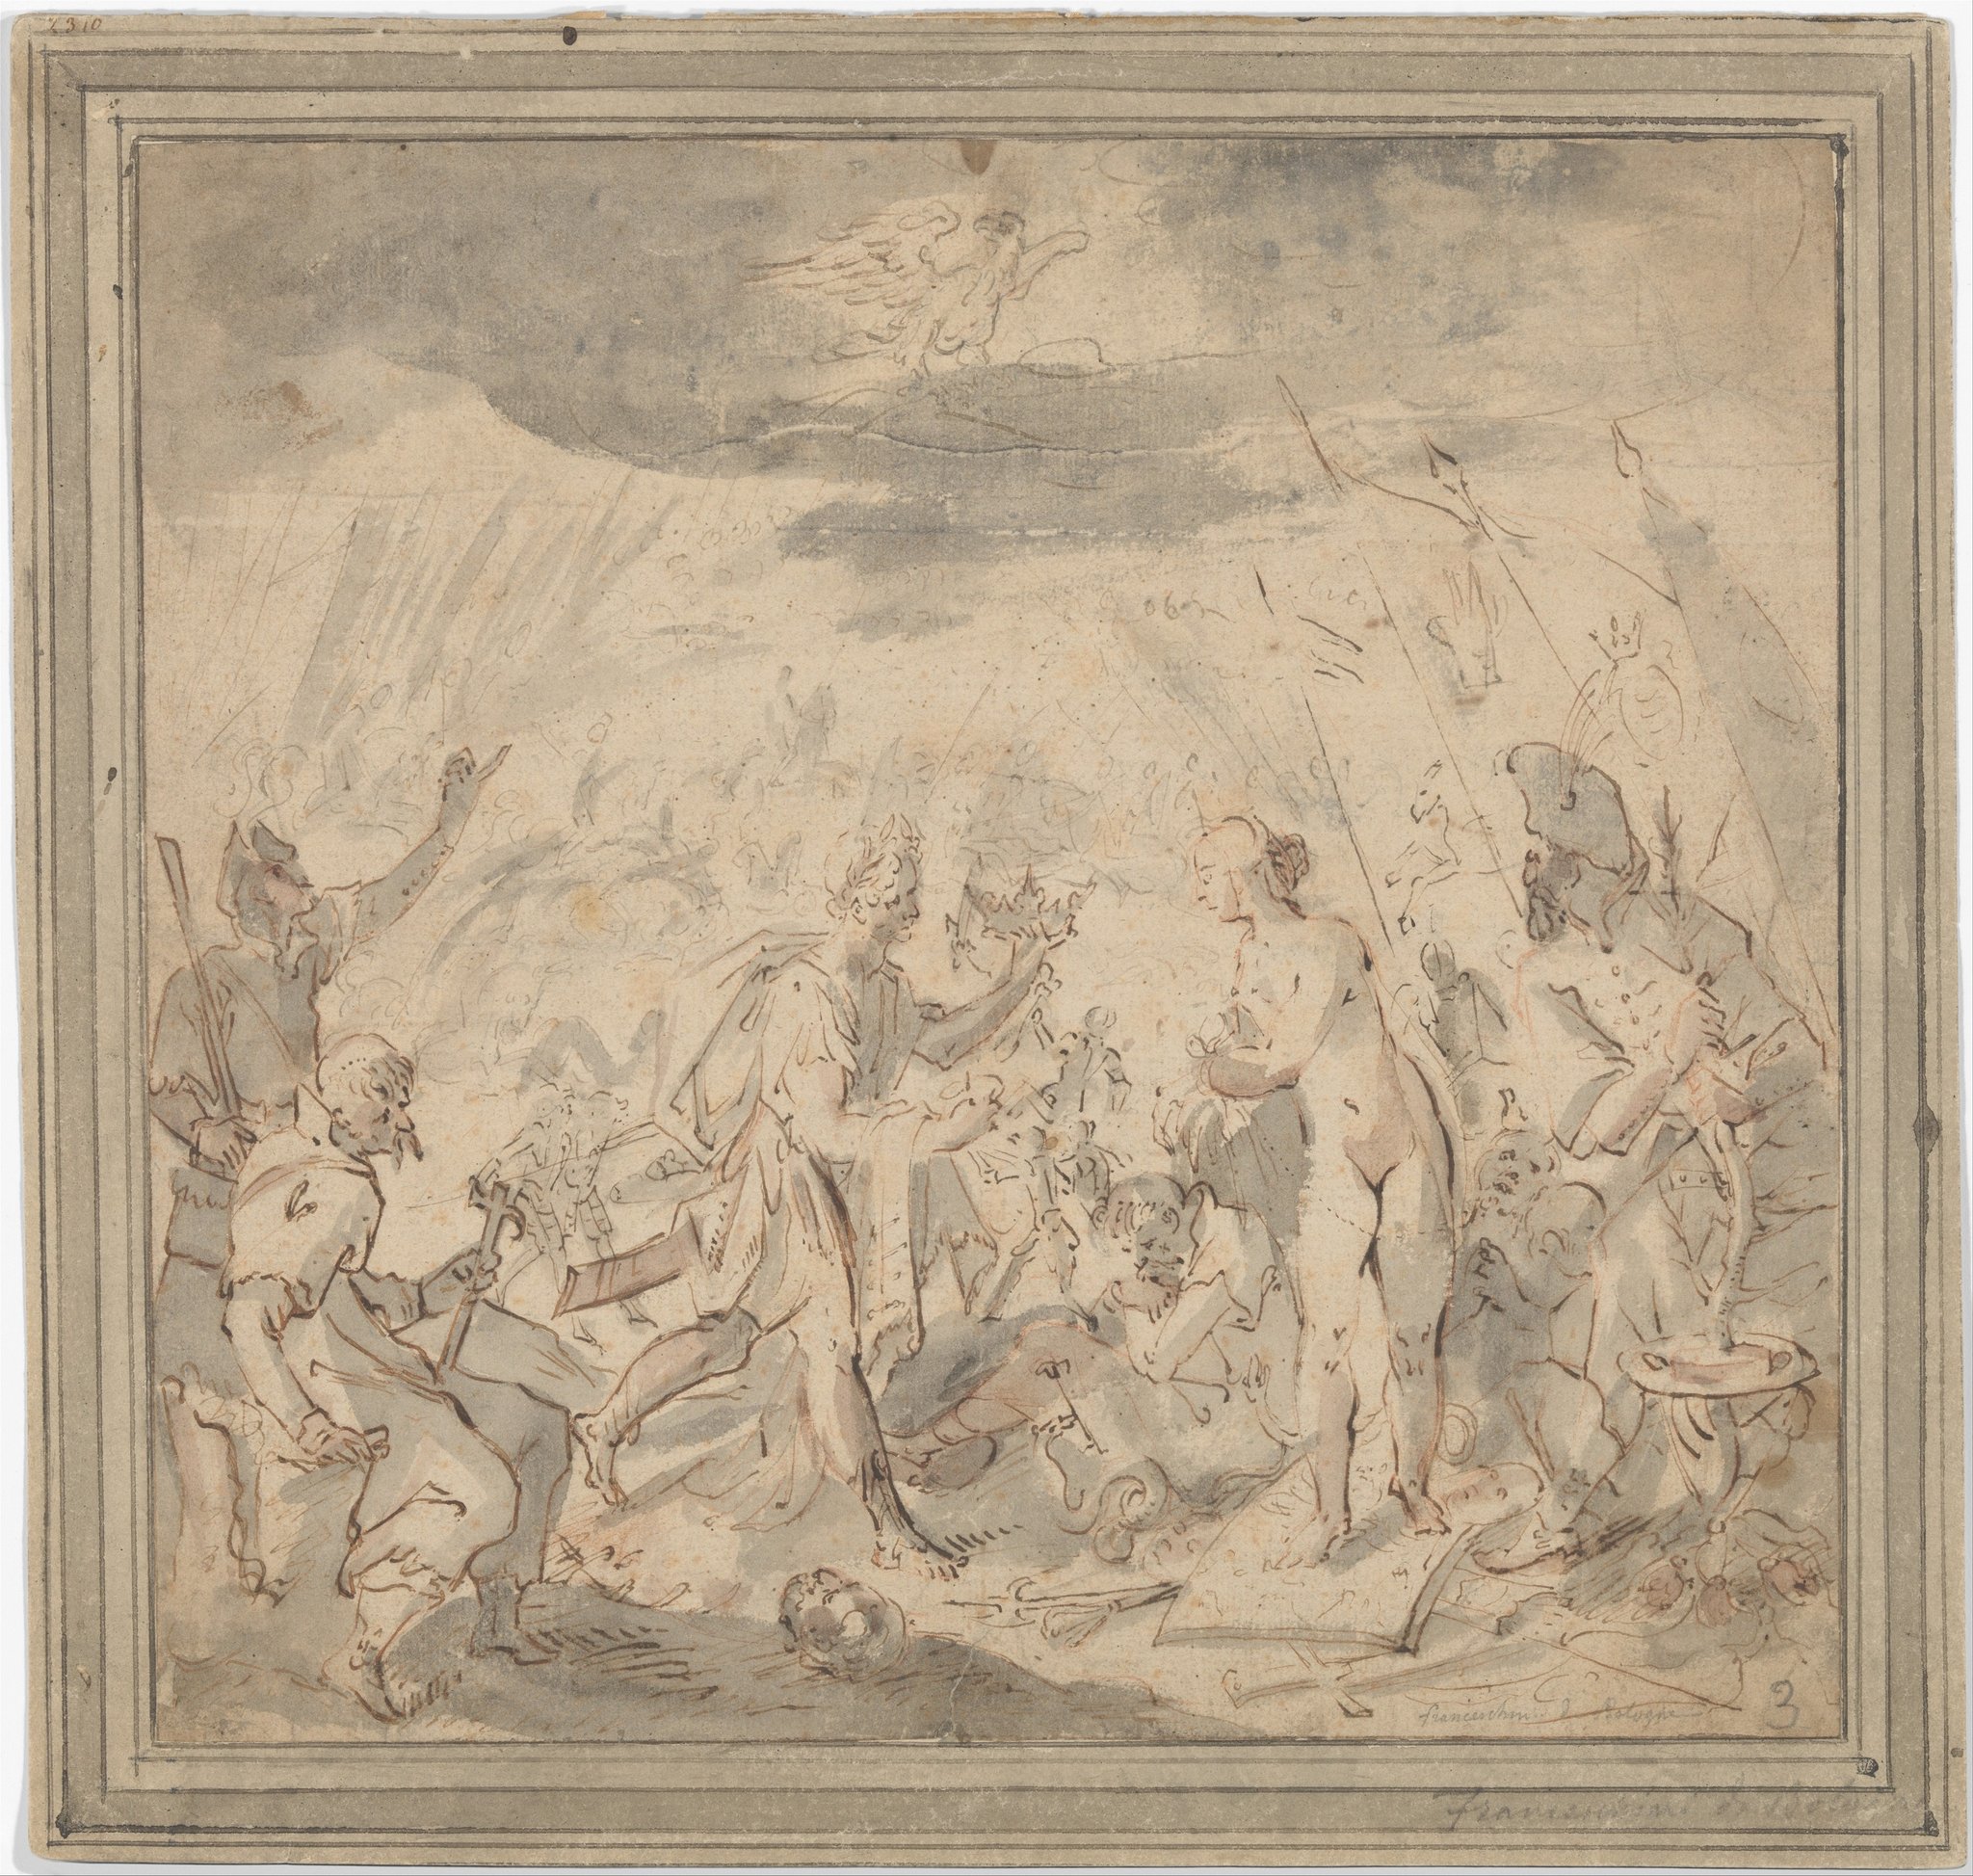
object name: drawing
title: Allegory of the Battle at Selimbar (October 28, 1599)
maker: hans von aachen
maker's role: artist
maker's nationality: german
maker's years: 1552-1616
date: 1552-1616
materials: chalk, ink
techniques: pen, wash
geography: germany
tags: eagles,weapons,men,female nudes